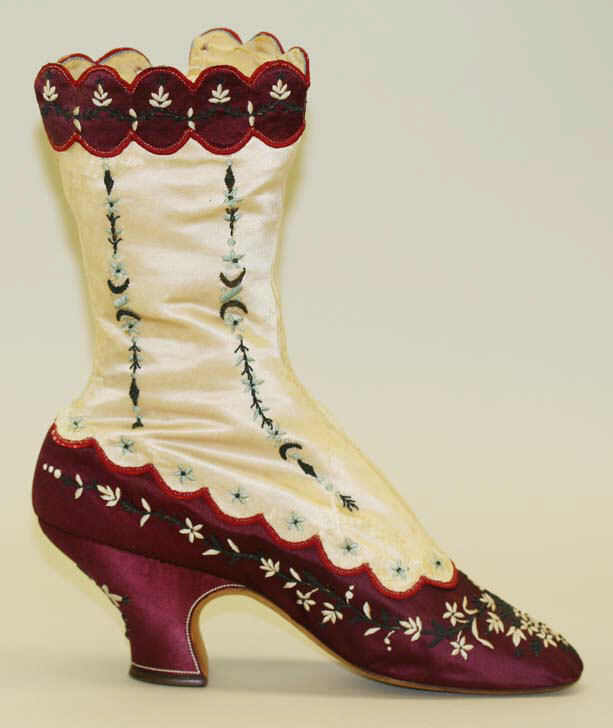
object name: boot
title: Boots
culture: italian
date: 1880-1889